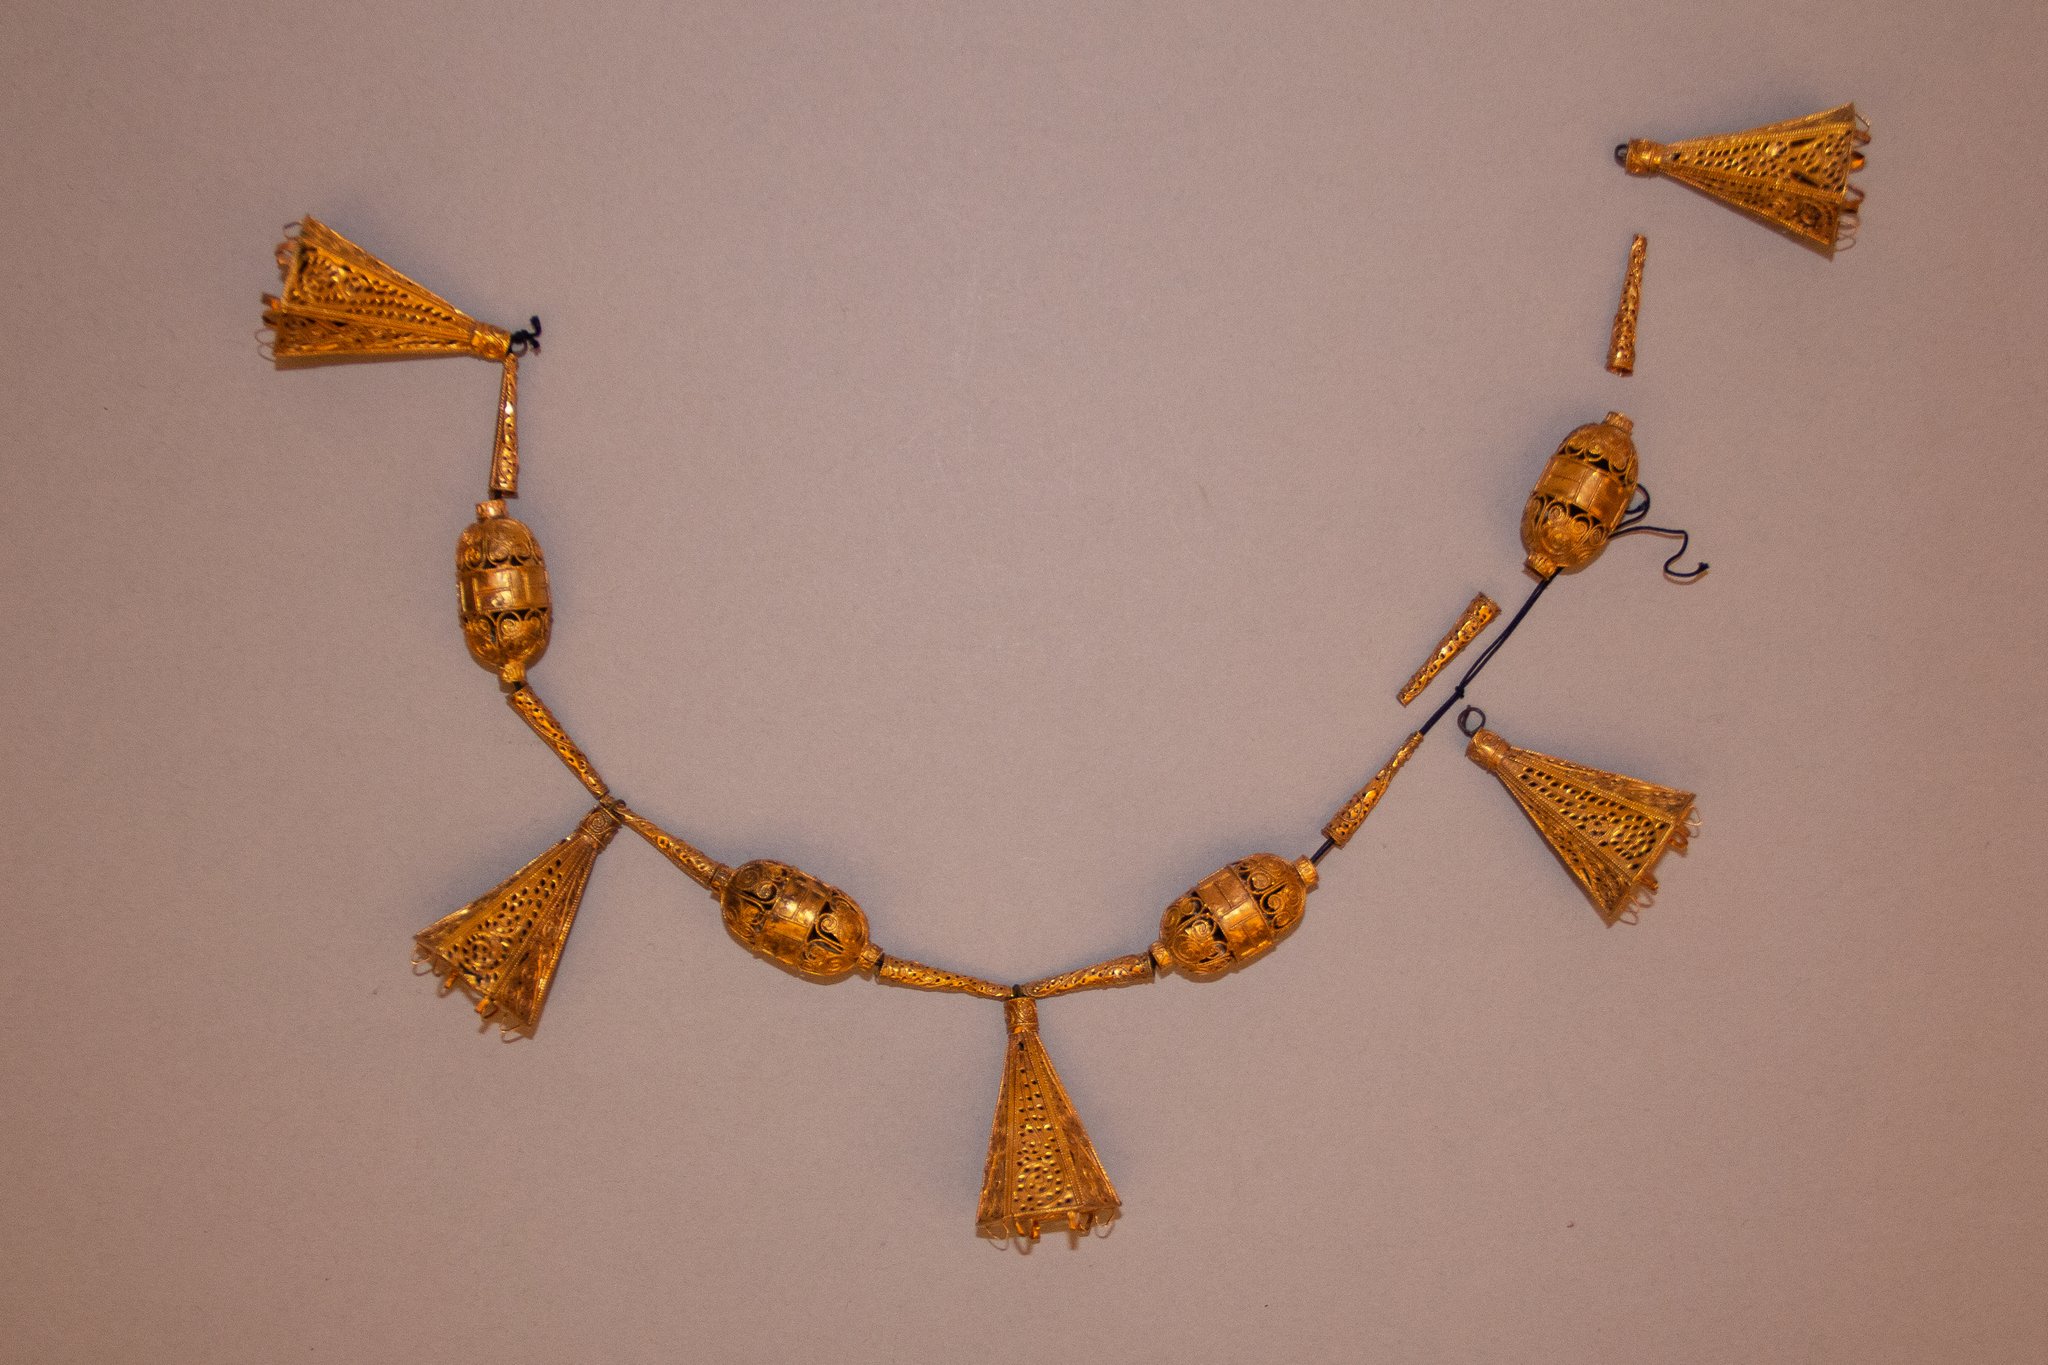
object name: necklace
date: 1301-1500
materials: gold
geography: spain